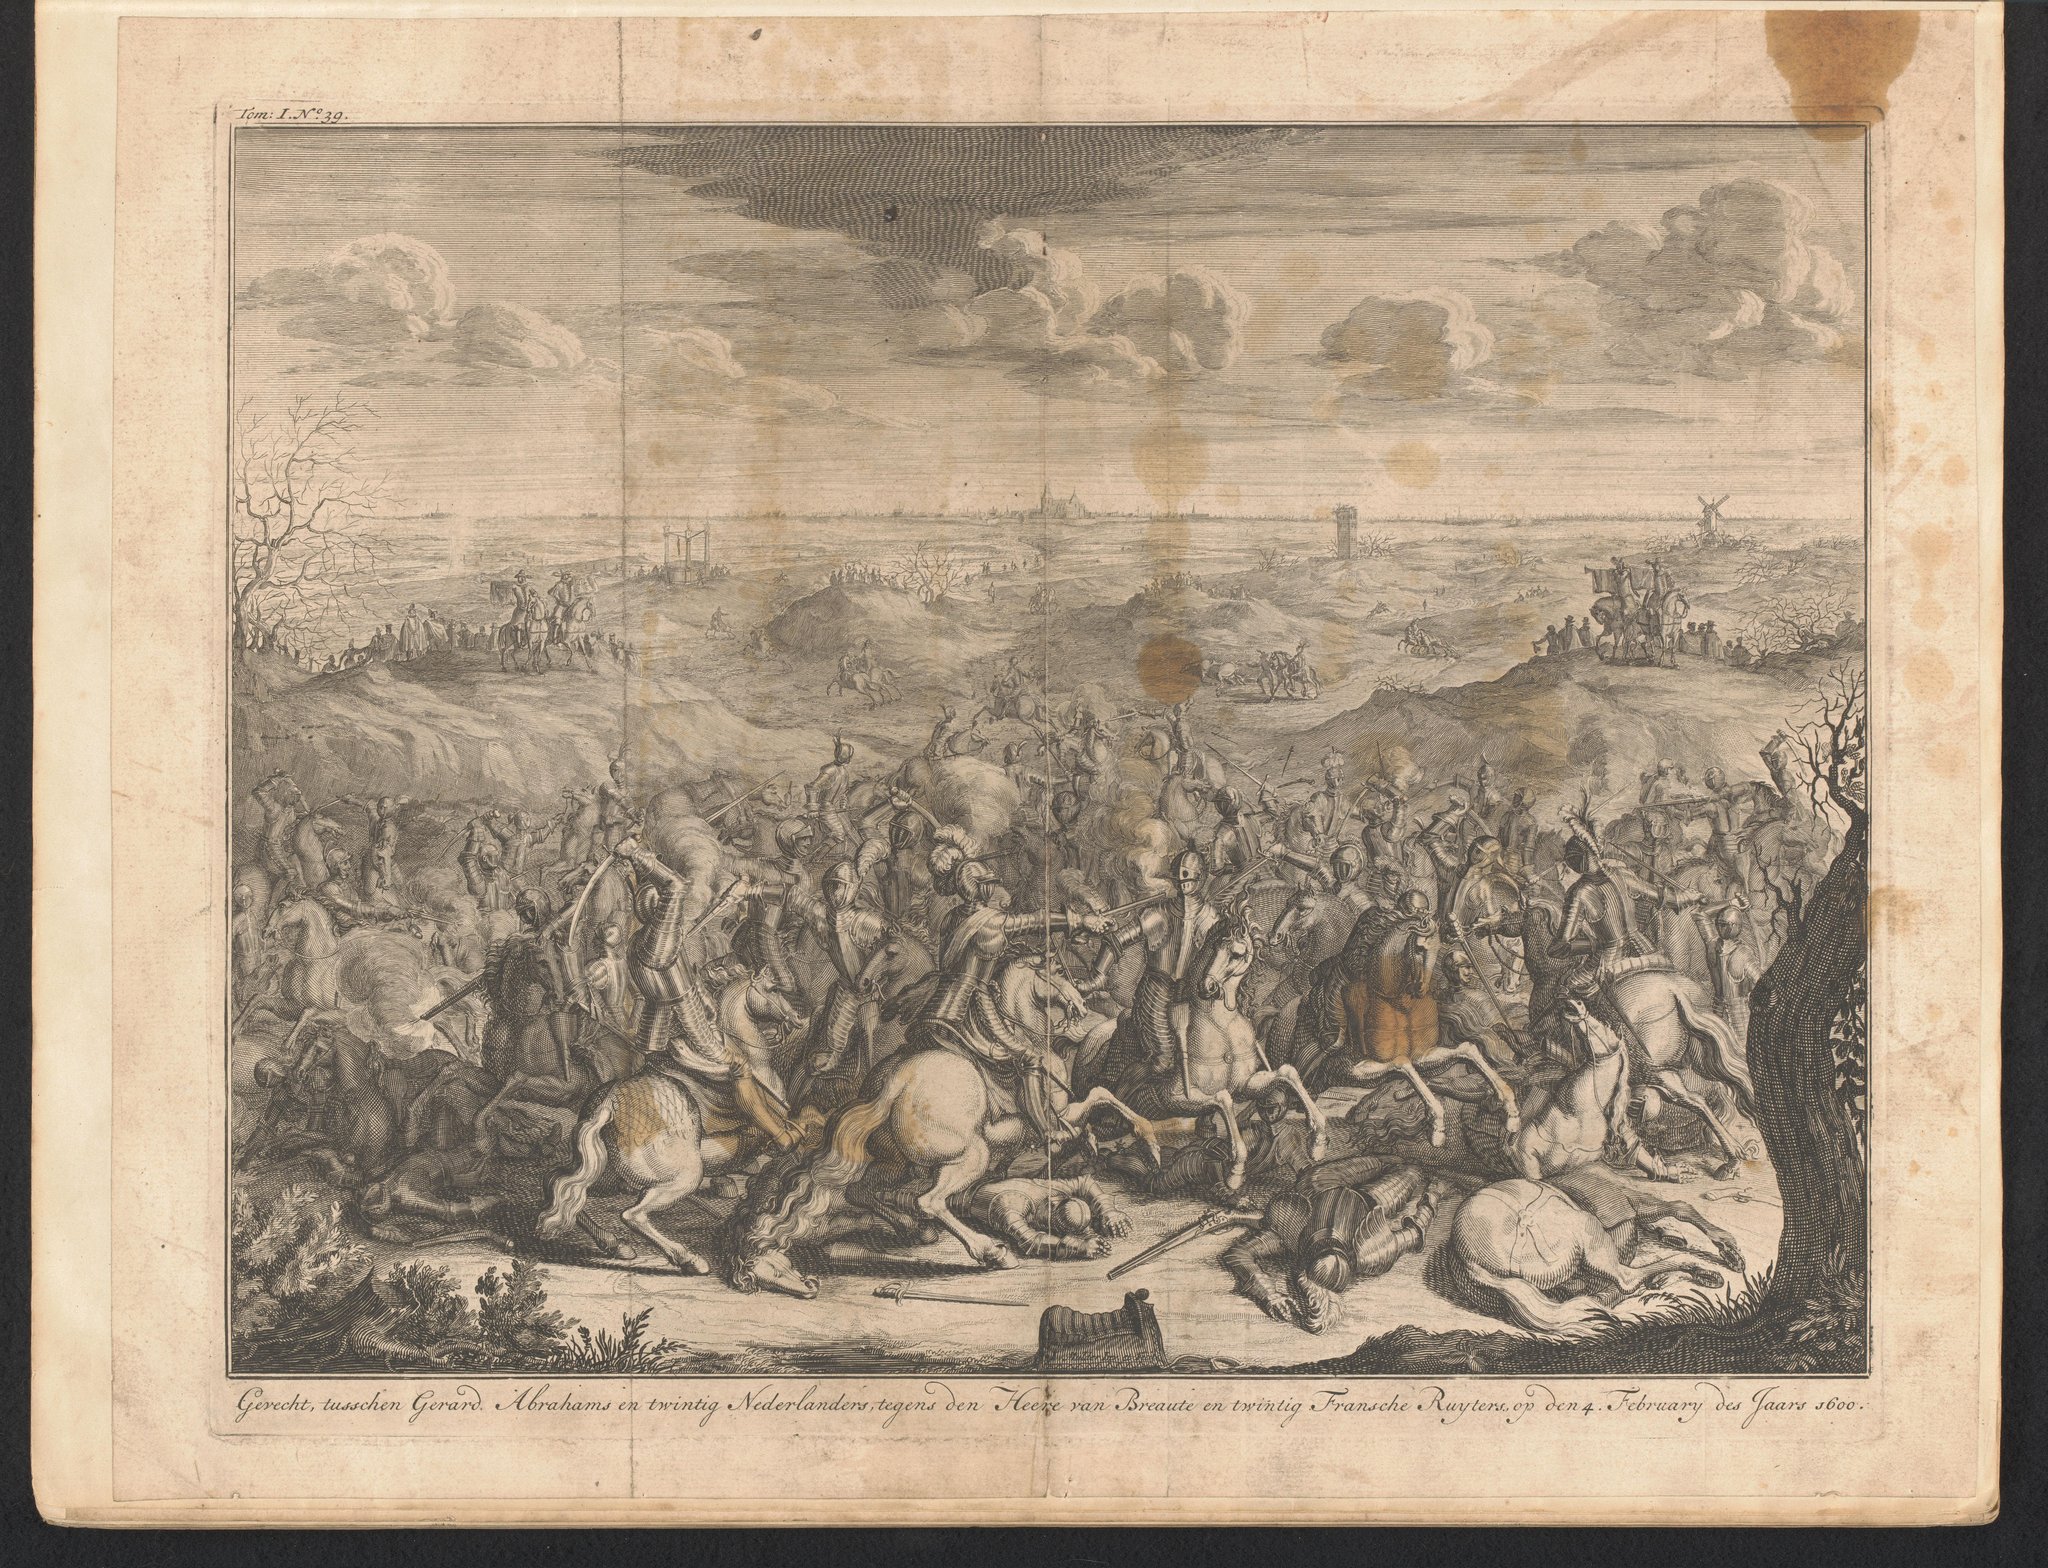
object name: print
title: Het gevecht van den Heere van Breaute met XX Fransche ruiters, tegens Geraerd Abrahamsz en XX Nederlanders, den IV van Februarius in den Jaere 1600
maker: joseph mulder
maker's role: print maker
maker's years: 1658-1718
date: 1730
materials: paper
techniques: etching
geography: northern netherlands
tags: battle, fighting in general (+ land forces), den bosch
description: Prent waarschijnlijk uit: Le Clerc, Jean. Geschiedenissen der Vereenigde Nederlanden, sedert den aanvang van die Republyk tot op den Vrede van Utrecht in 't jaar 1713 en het Tractaat van Barriere in 't jaar 1715 gesloten. Amsterdam: Zacharias Chatelain, 1730. Eerdere staat gebruikt in: Bor, Pieter Christiaensz. Oorsprongk, begin, en vervolgh der Nederlandsche Oorlogen (...), Amsterdam: weduwe van Joannes van Someren, Abraham Wolfgangh, Hendrick en Dirk Boom, 1679-1684, dl. 4.